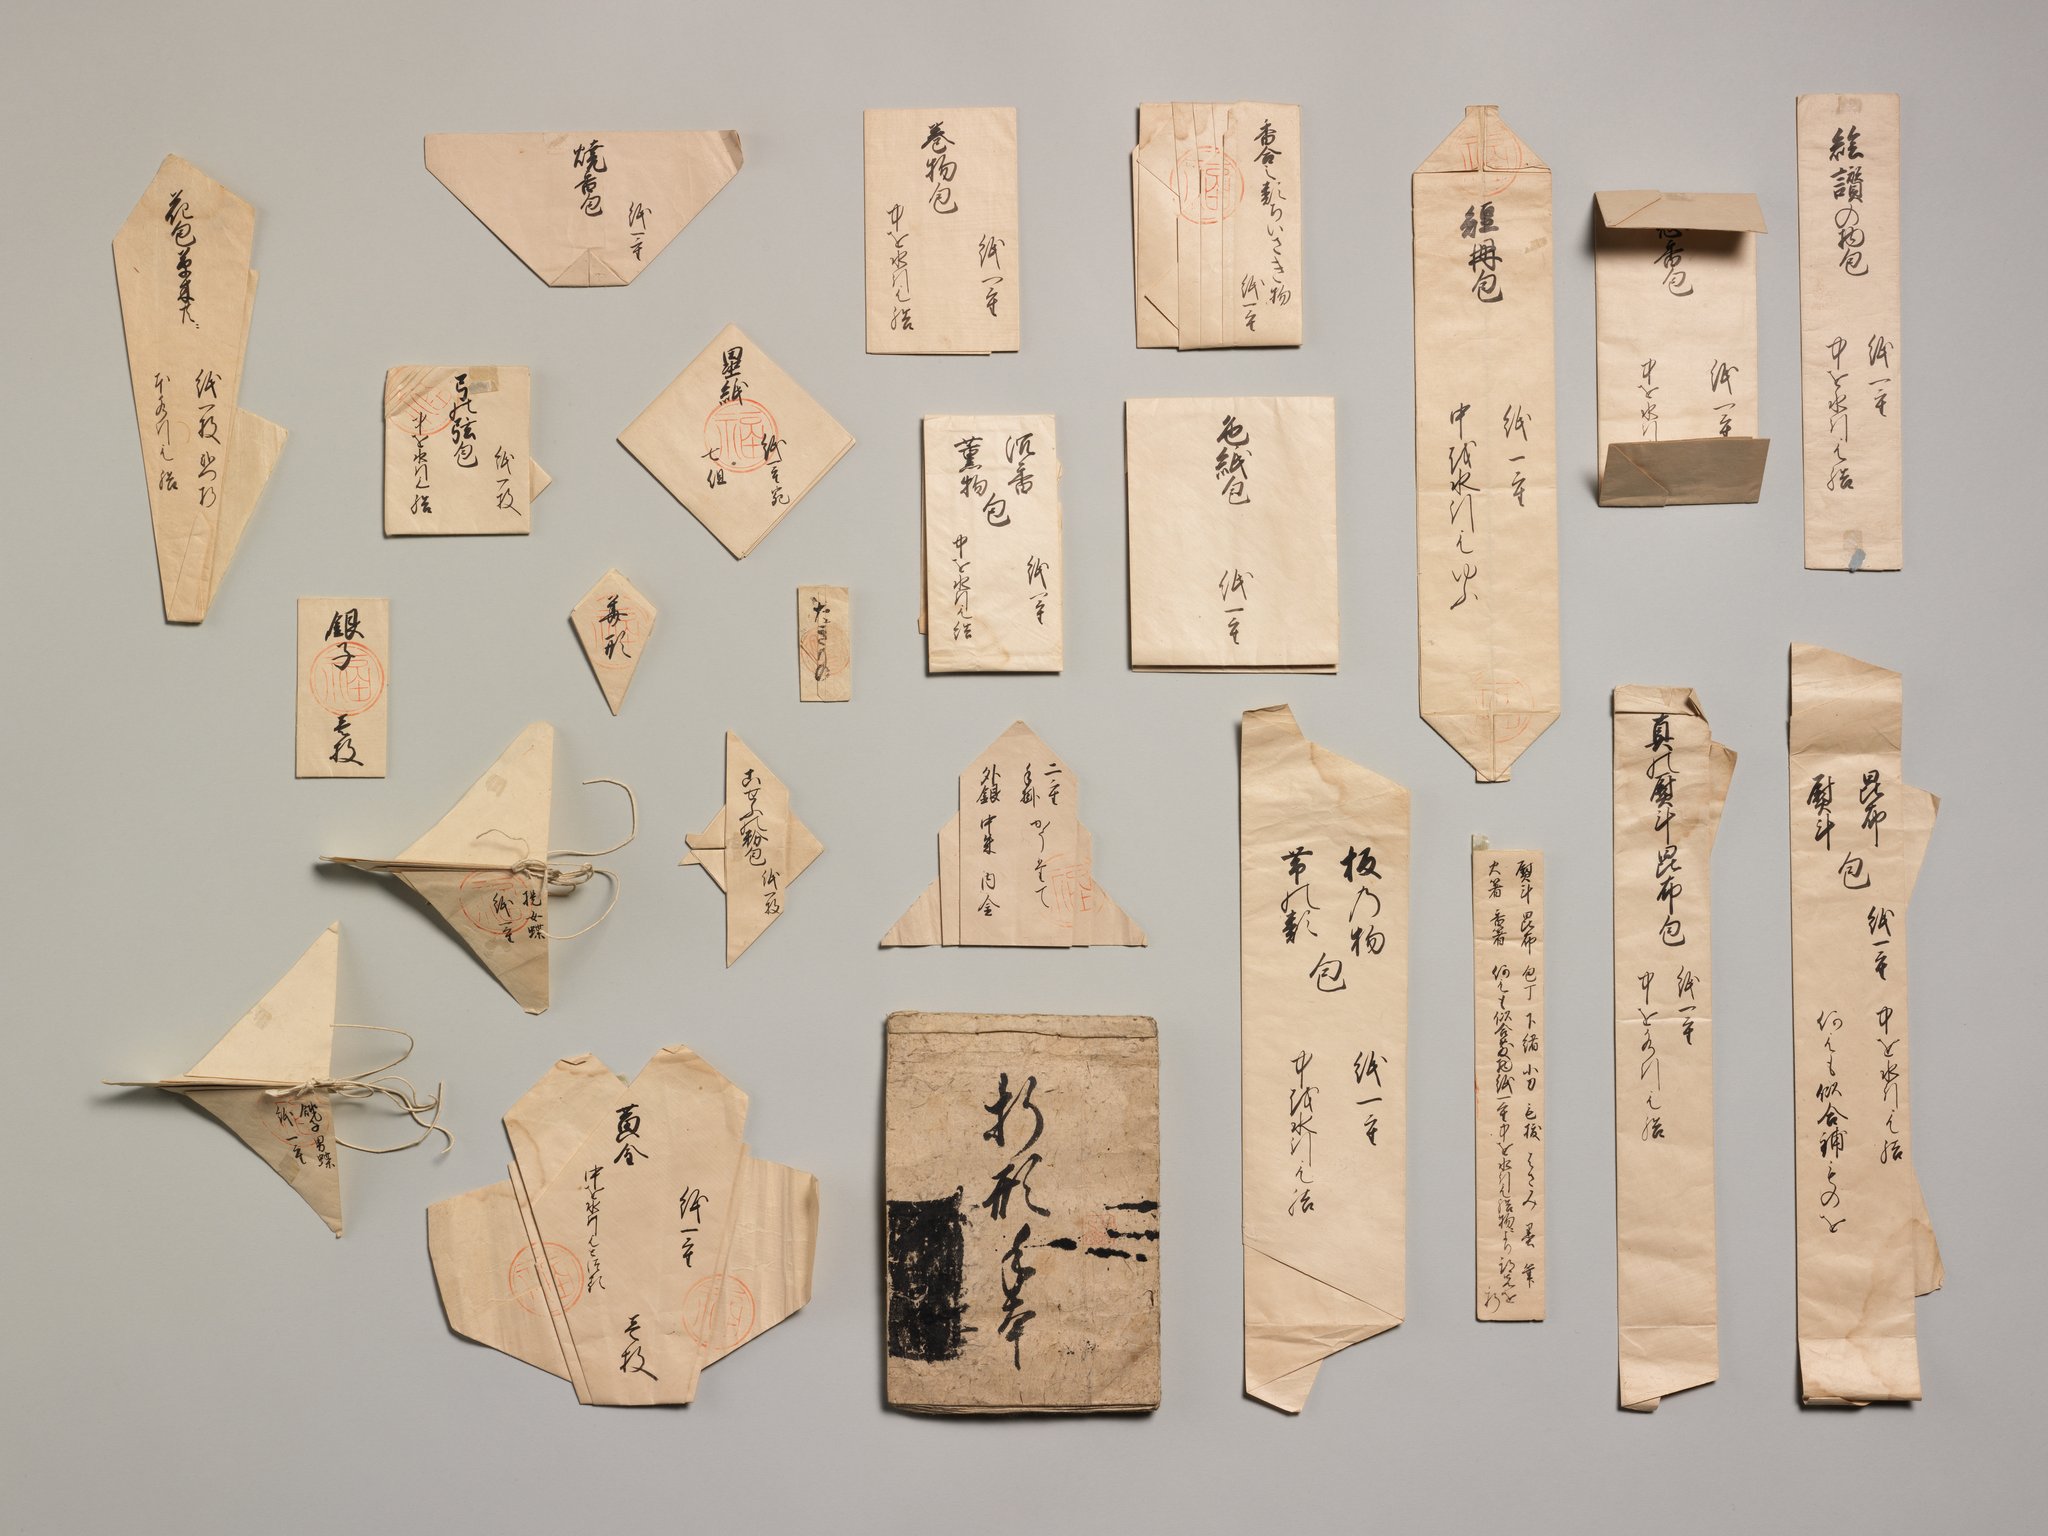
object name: illustrated book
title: Models of Paper Folding (Origata tehon)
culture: japanese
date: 1697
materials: ink, paper